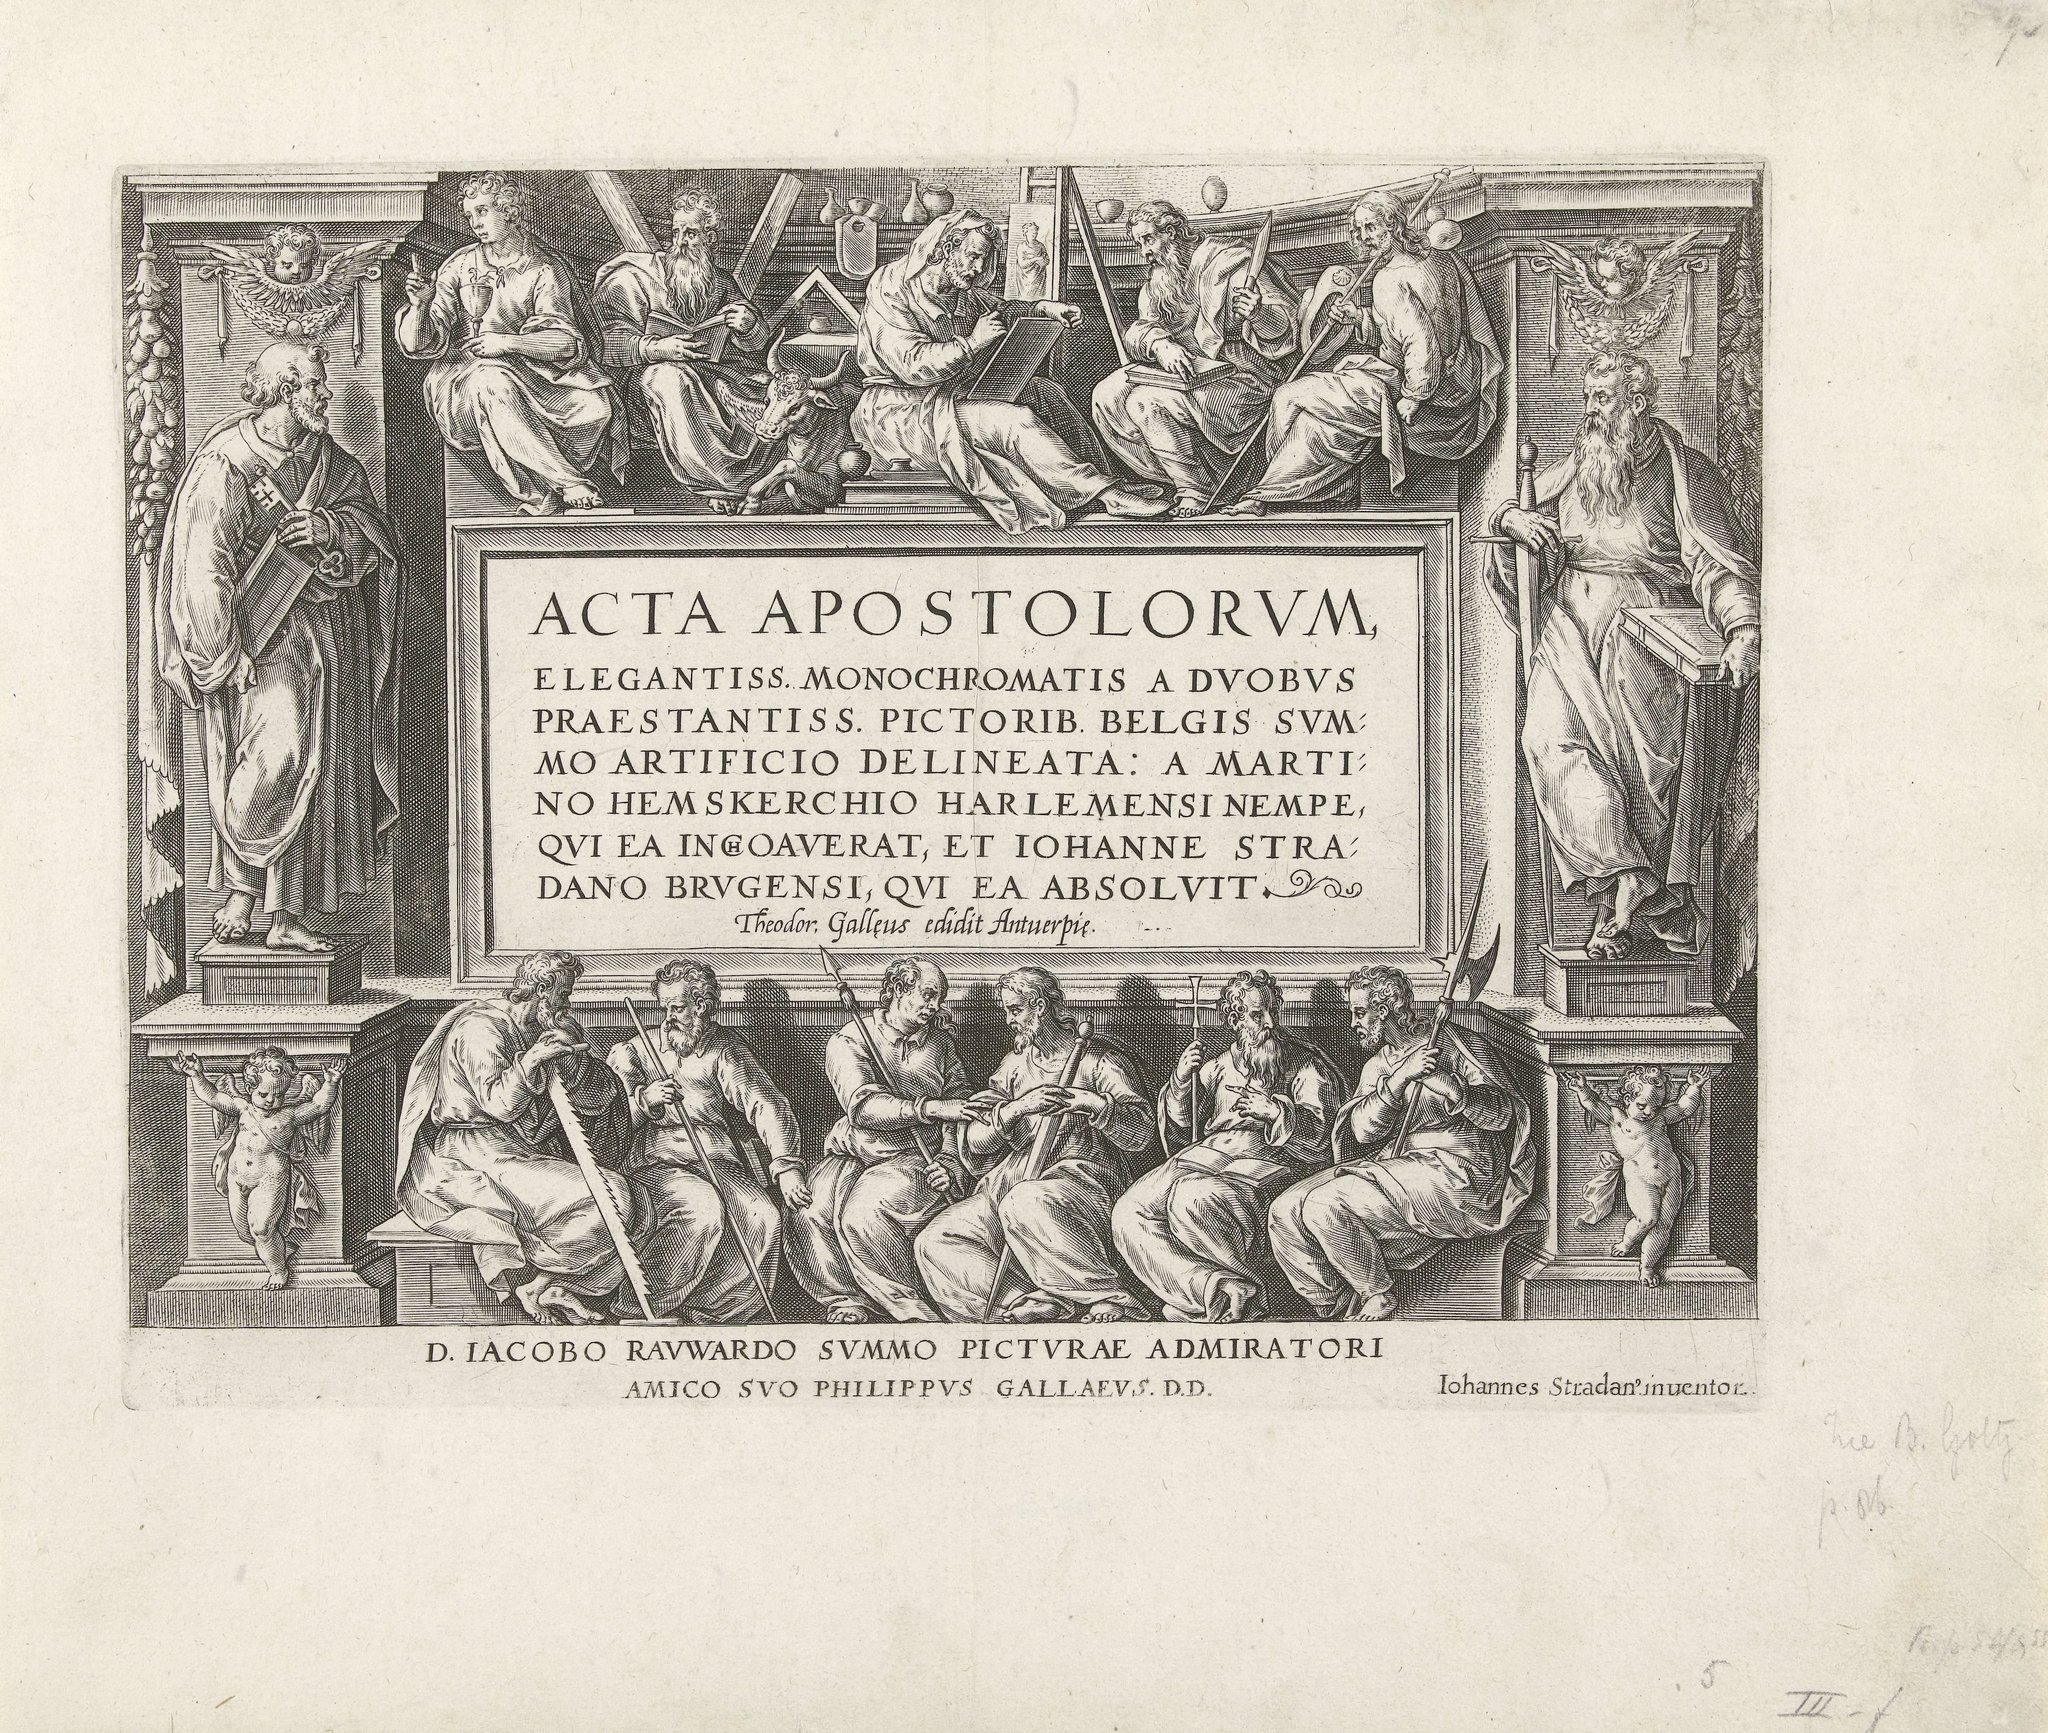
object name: print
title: Acta Apostolorum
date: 1582-1633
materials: paper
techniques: engraving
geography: antwerp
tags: the twelve apostles (as a group), usually with books or scrolls (not in biblical context), lives and acts of the apostles (part i)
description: Centraal in een kader de titel Acta Apostolorum. Rondom het kader elf apostelen. Links van het kader de apostel Petrus. Rechts van het kader de apostel Paulus. De apostelen zijn afgebeeld met hun attributen. De prent is de titelprent van een 34-delige serie over de Handelingen van de apostelen.